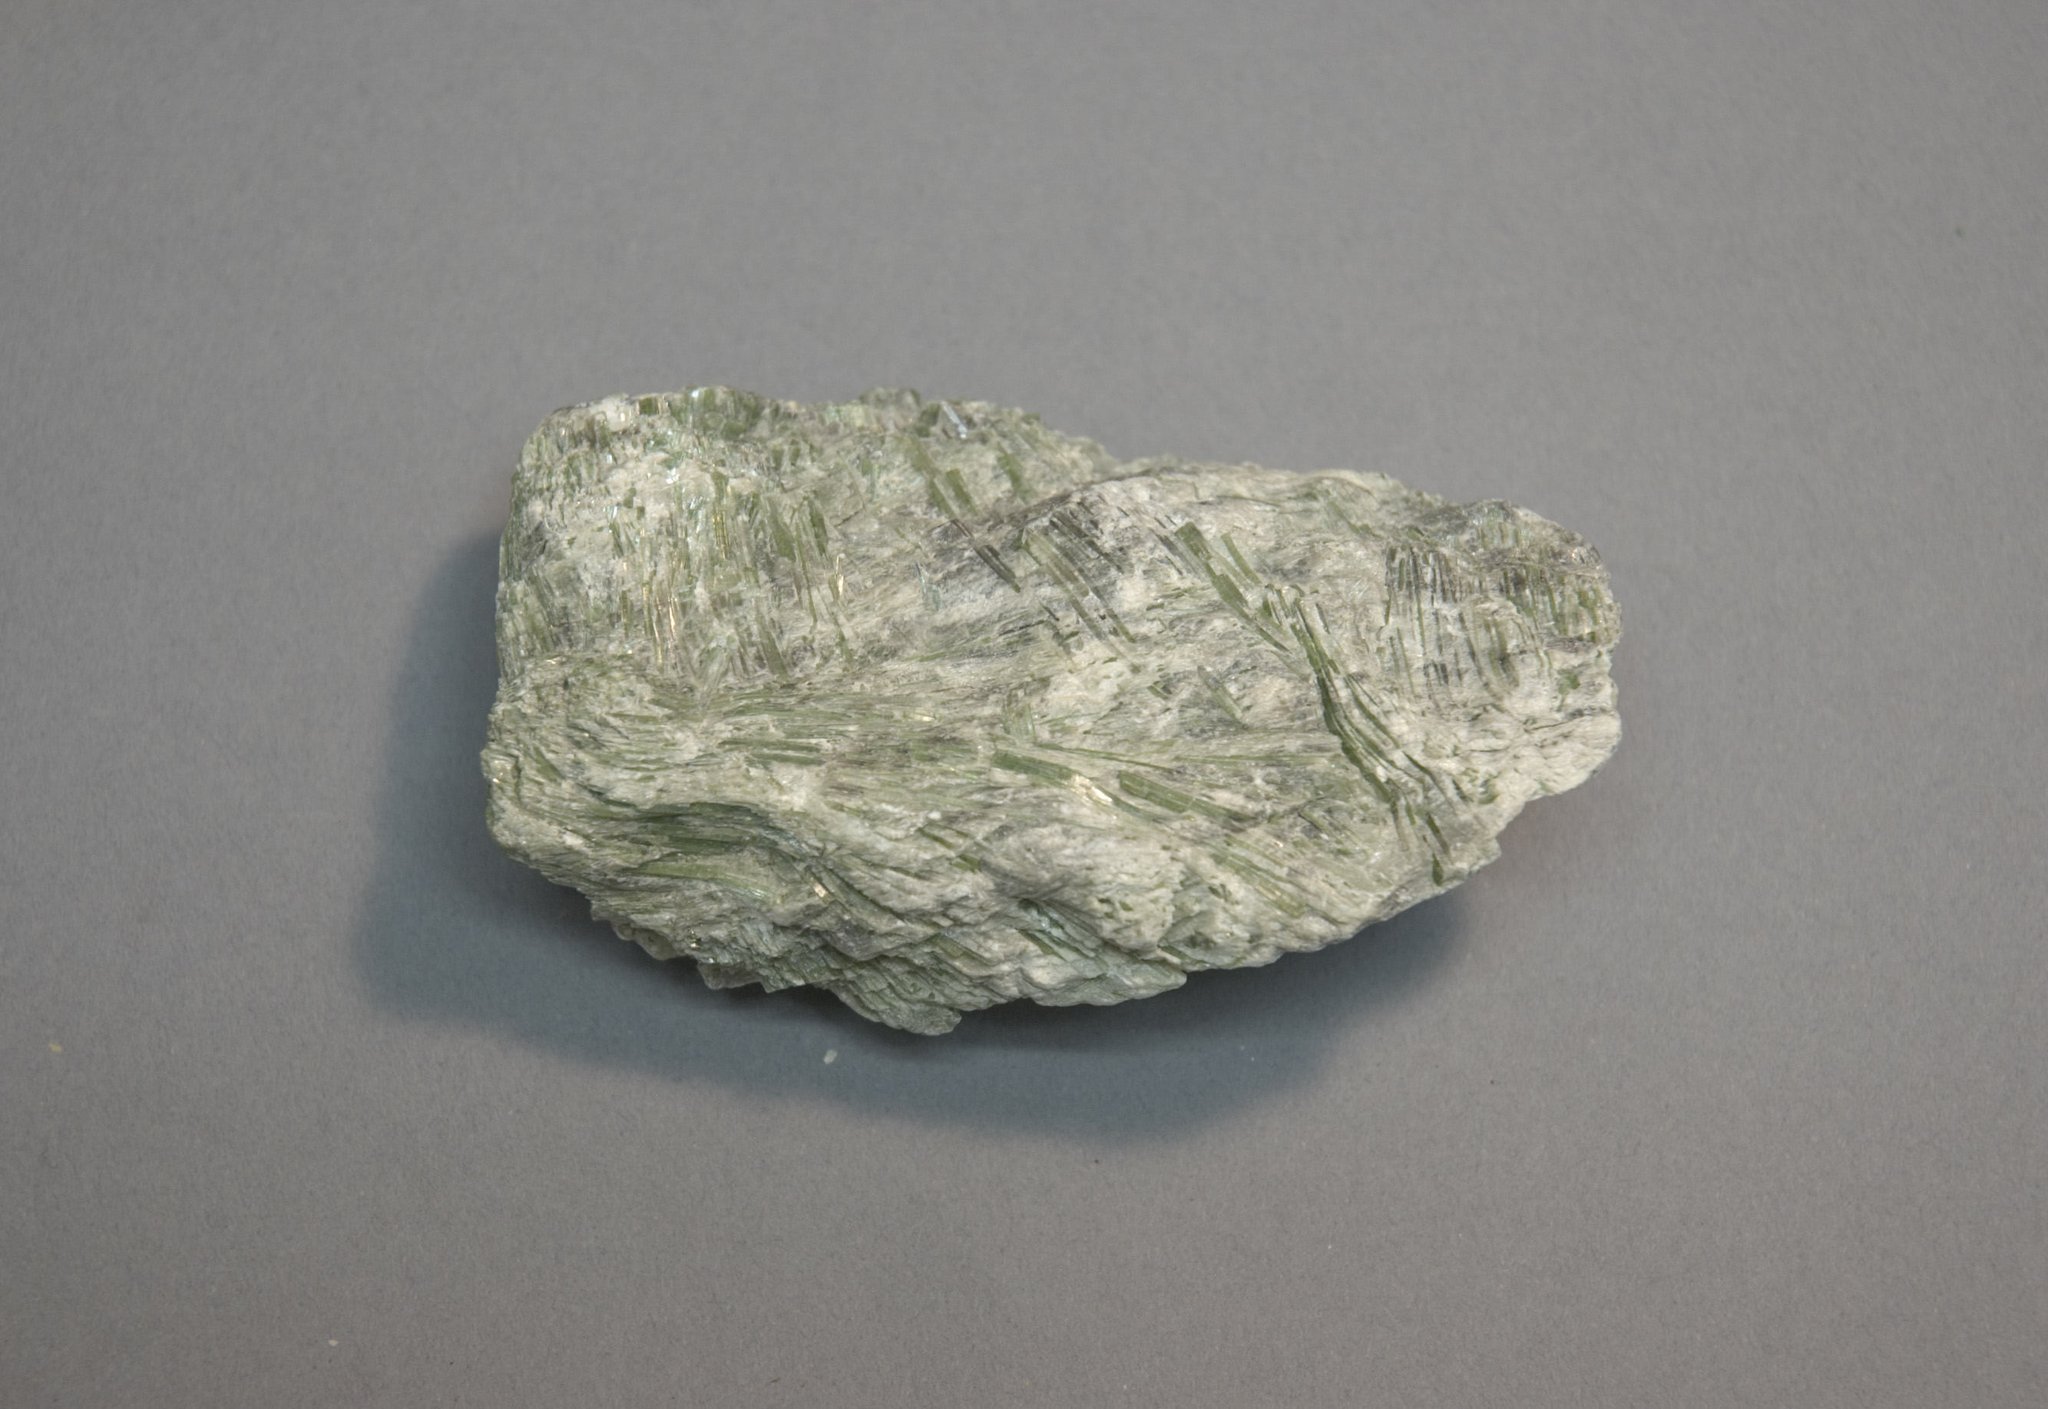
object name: jade carving material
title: Sample of Amphibole Asbestos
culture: chinese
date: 1901-2000